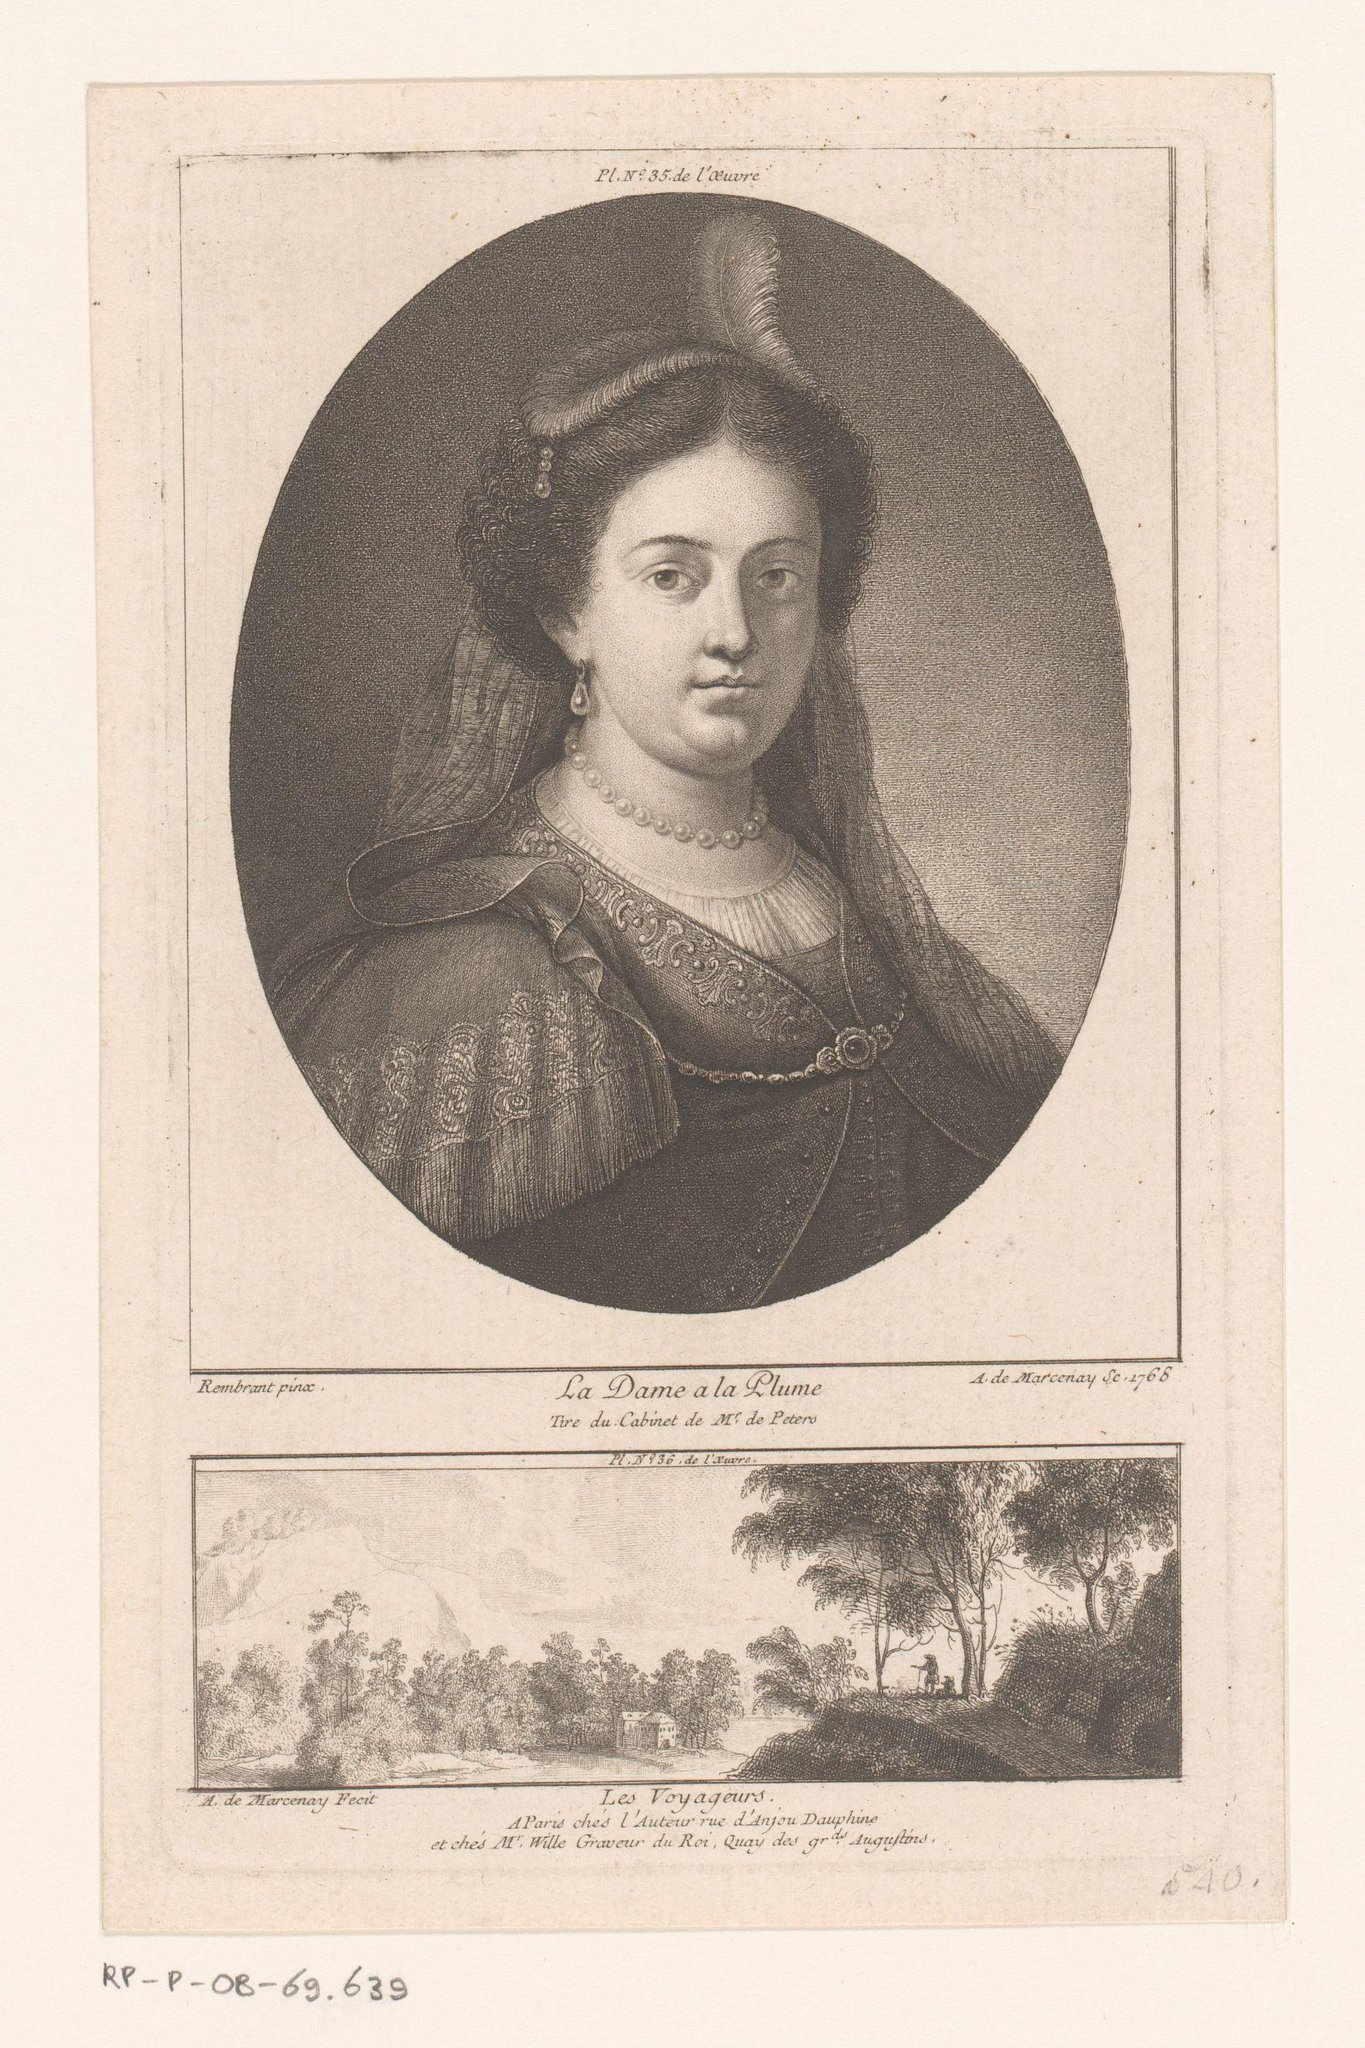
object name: print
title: Portret van Saskia van Uylenburgh en landschap met reizigers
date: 1768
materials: paper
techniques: etching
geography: paris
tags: amsterdam, historical persons, 'en route', traveller under way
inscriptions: collector's mark: Lugt 240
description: Dit betreft de eerste staat van de prent. Vanaf de tweede staat zijn de twee scènes van elkaar gescheiden en afzonderlijk uitgegeven (British Museum, inv.nr. 1840,0314.84).